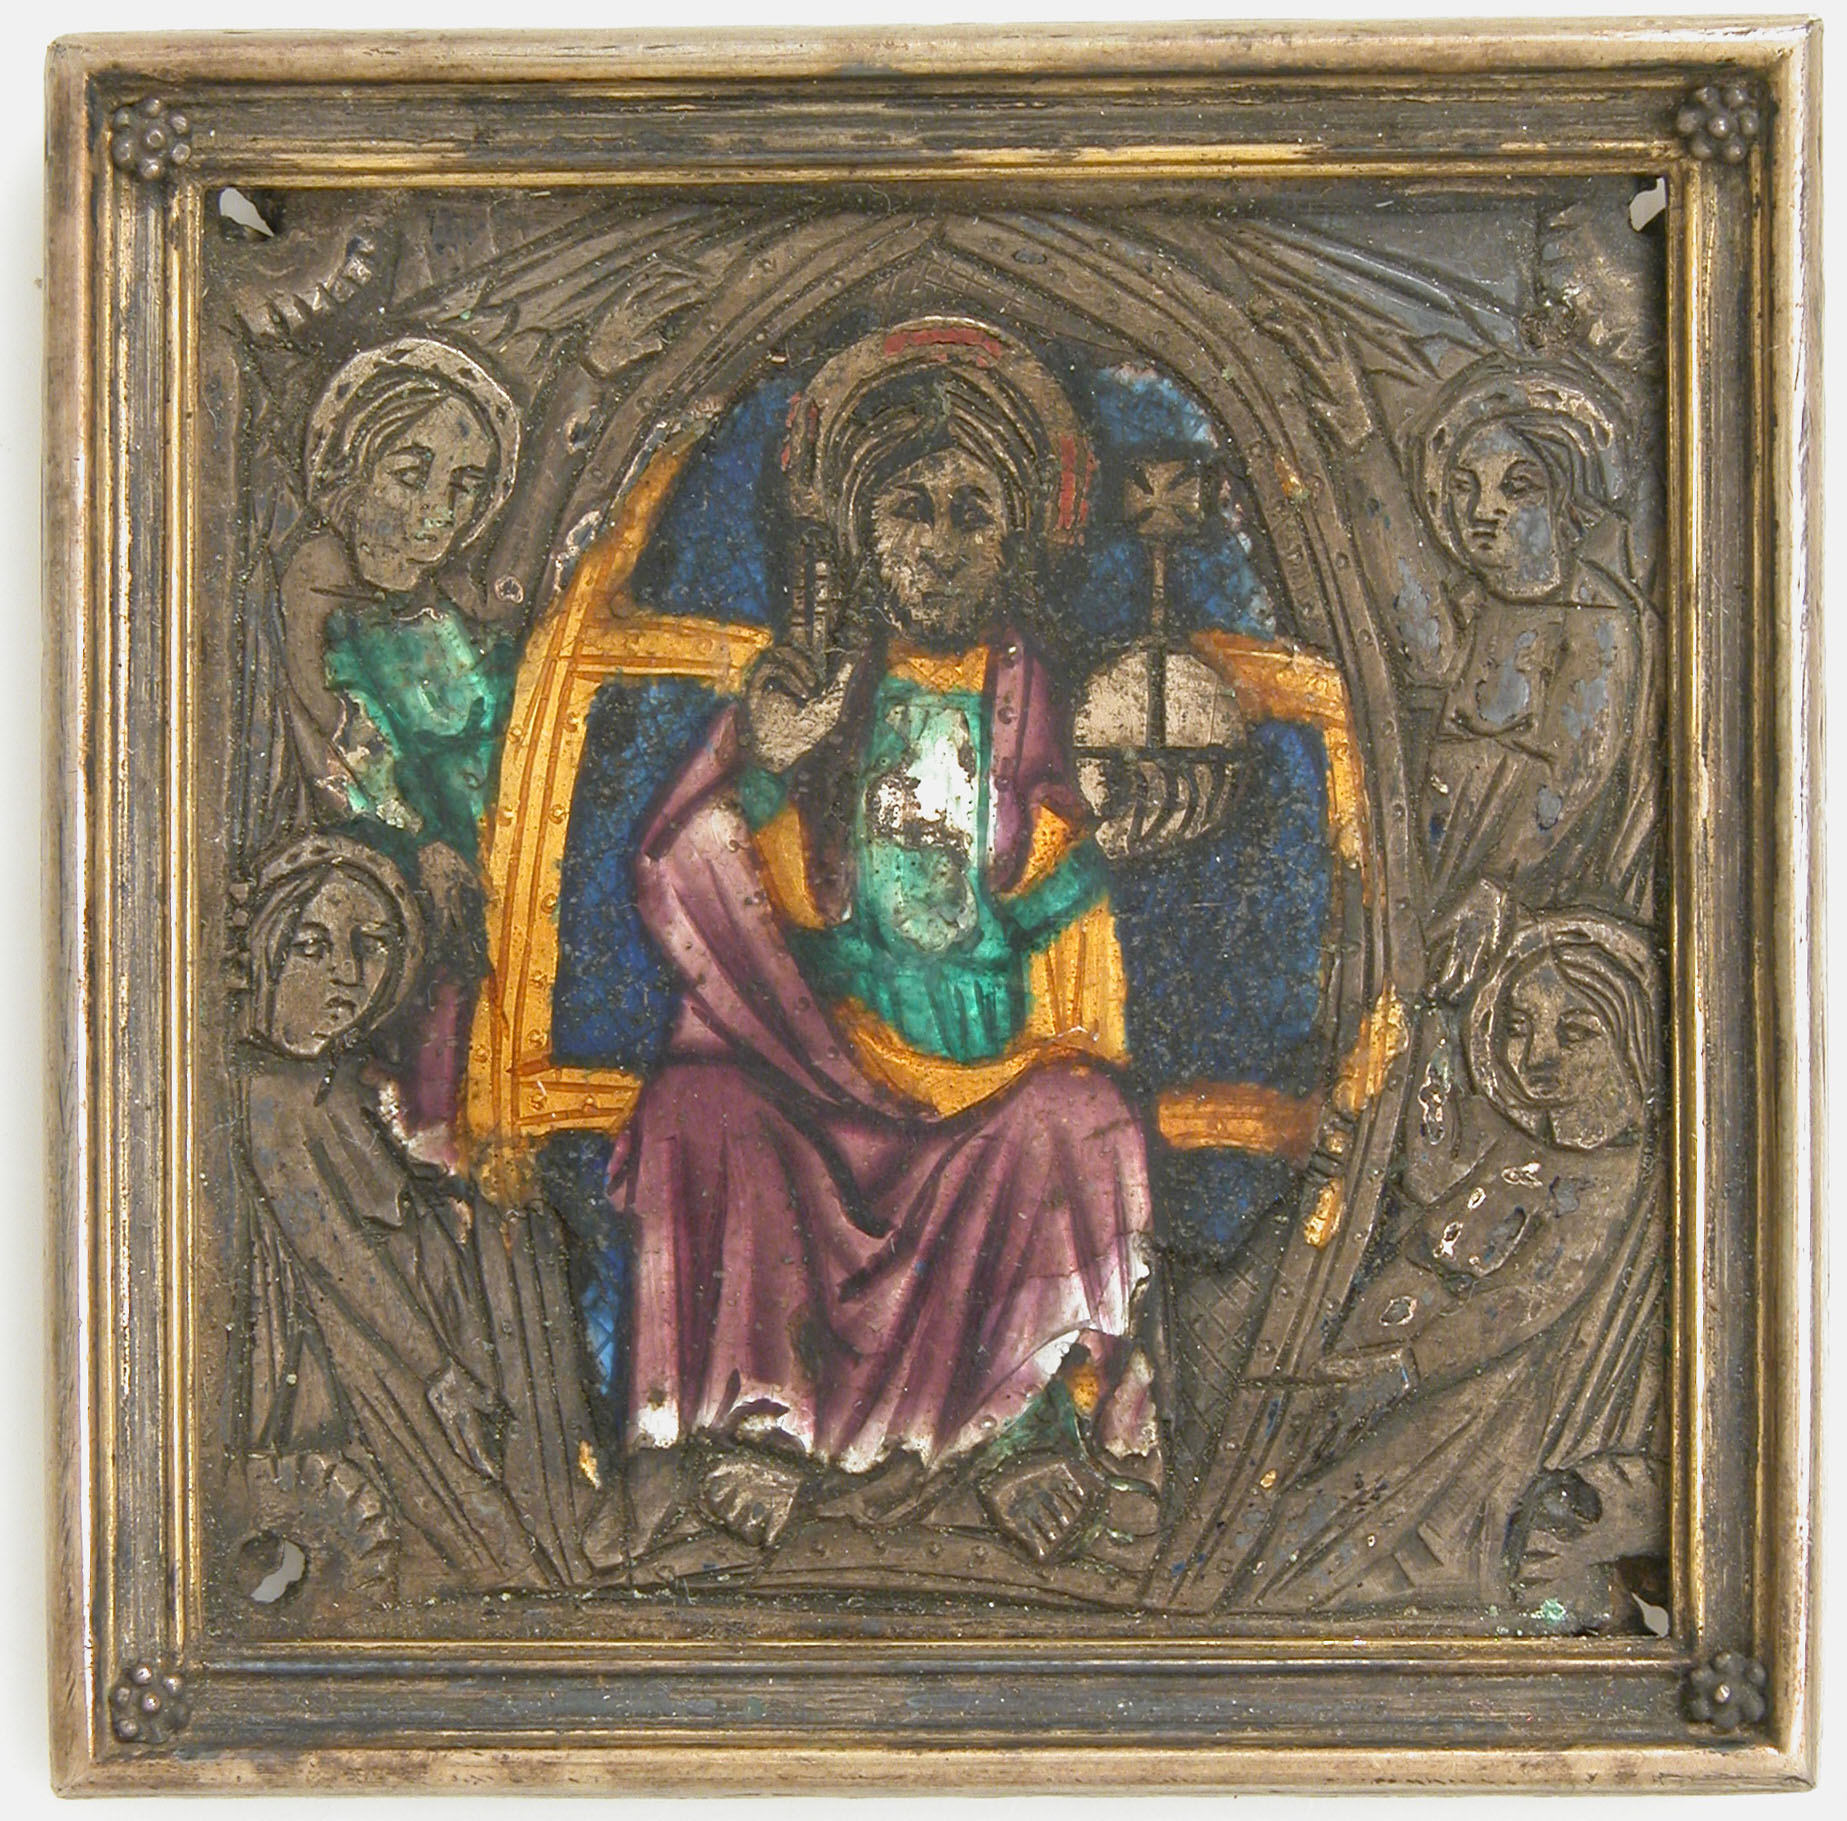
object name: plaque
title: Plaque with Christ in Majesty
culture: spanish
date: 1301-1400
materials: enamel, silver